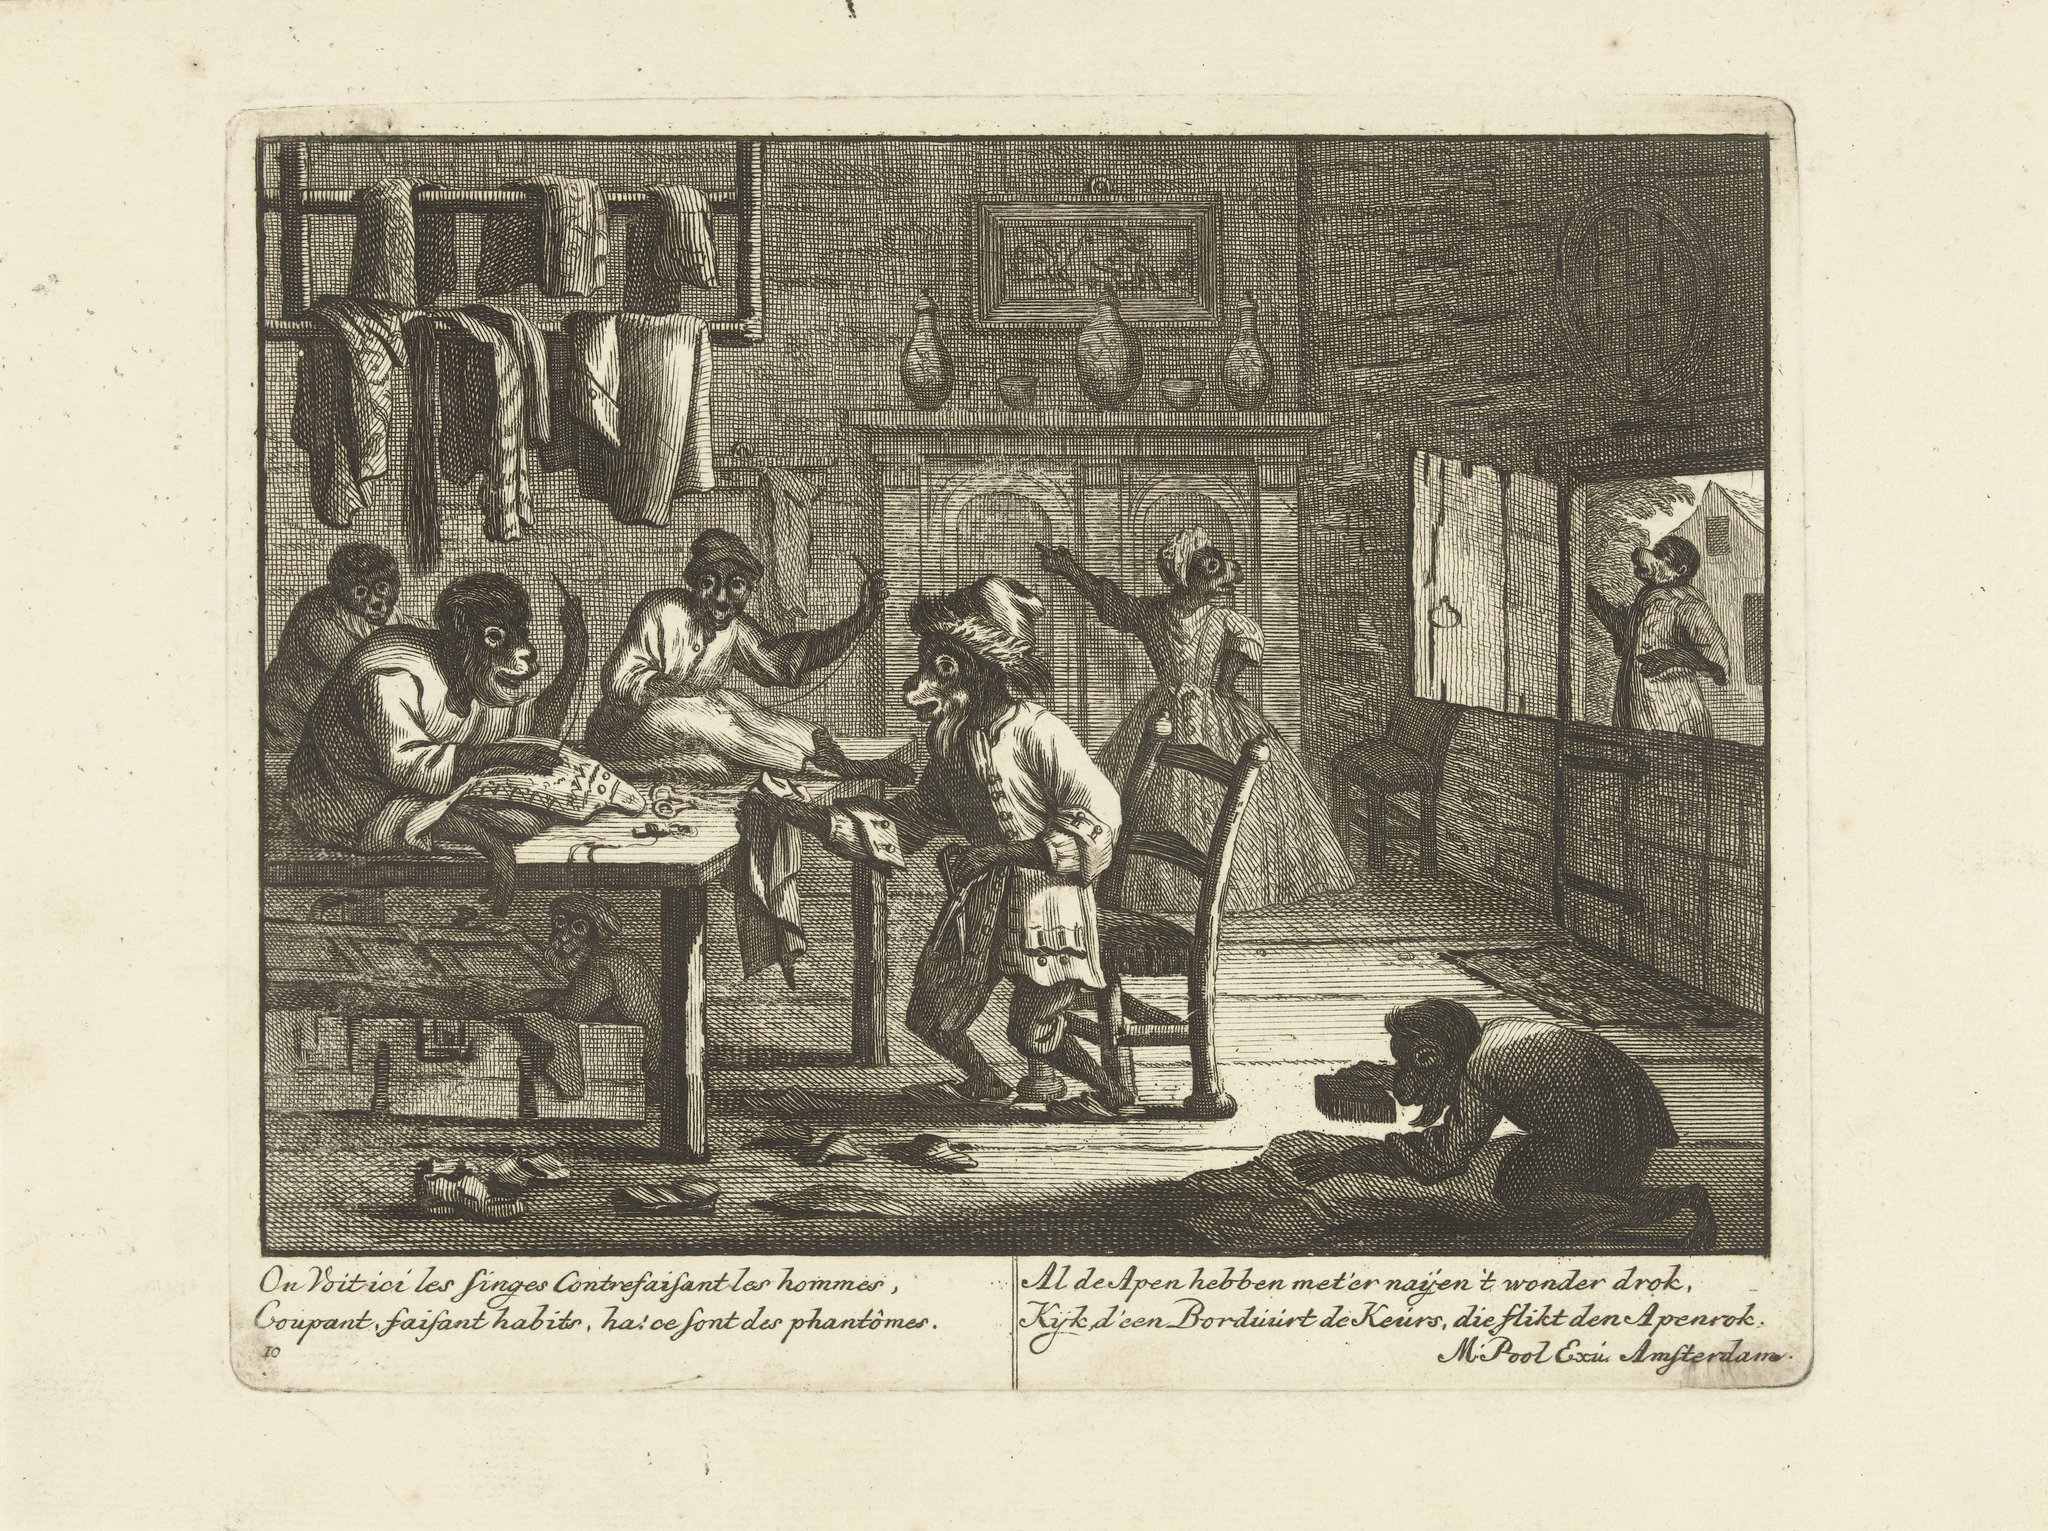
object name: print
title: Apenspel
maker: matthijs pool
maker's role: print maker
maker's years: 1676-1740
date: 1720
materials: paper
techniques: engraving, etching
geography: amsterdam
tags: monkeys, apes, animals acting as human beings, tailor, dressmaker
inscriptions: collector's mark: Lugt 2228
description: Apen werkzaam als kleeermakers. In het onderschrift versjes in het Frans en Nederlands. Prent nr. 10 in een serie van 16 prenten van ca. 1720 waarin apen als mensen figureren in allerlei huishoudelijke taferelen.